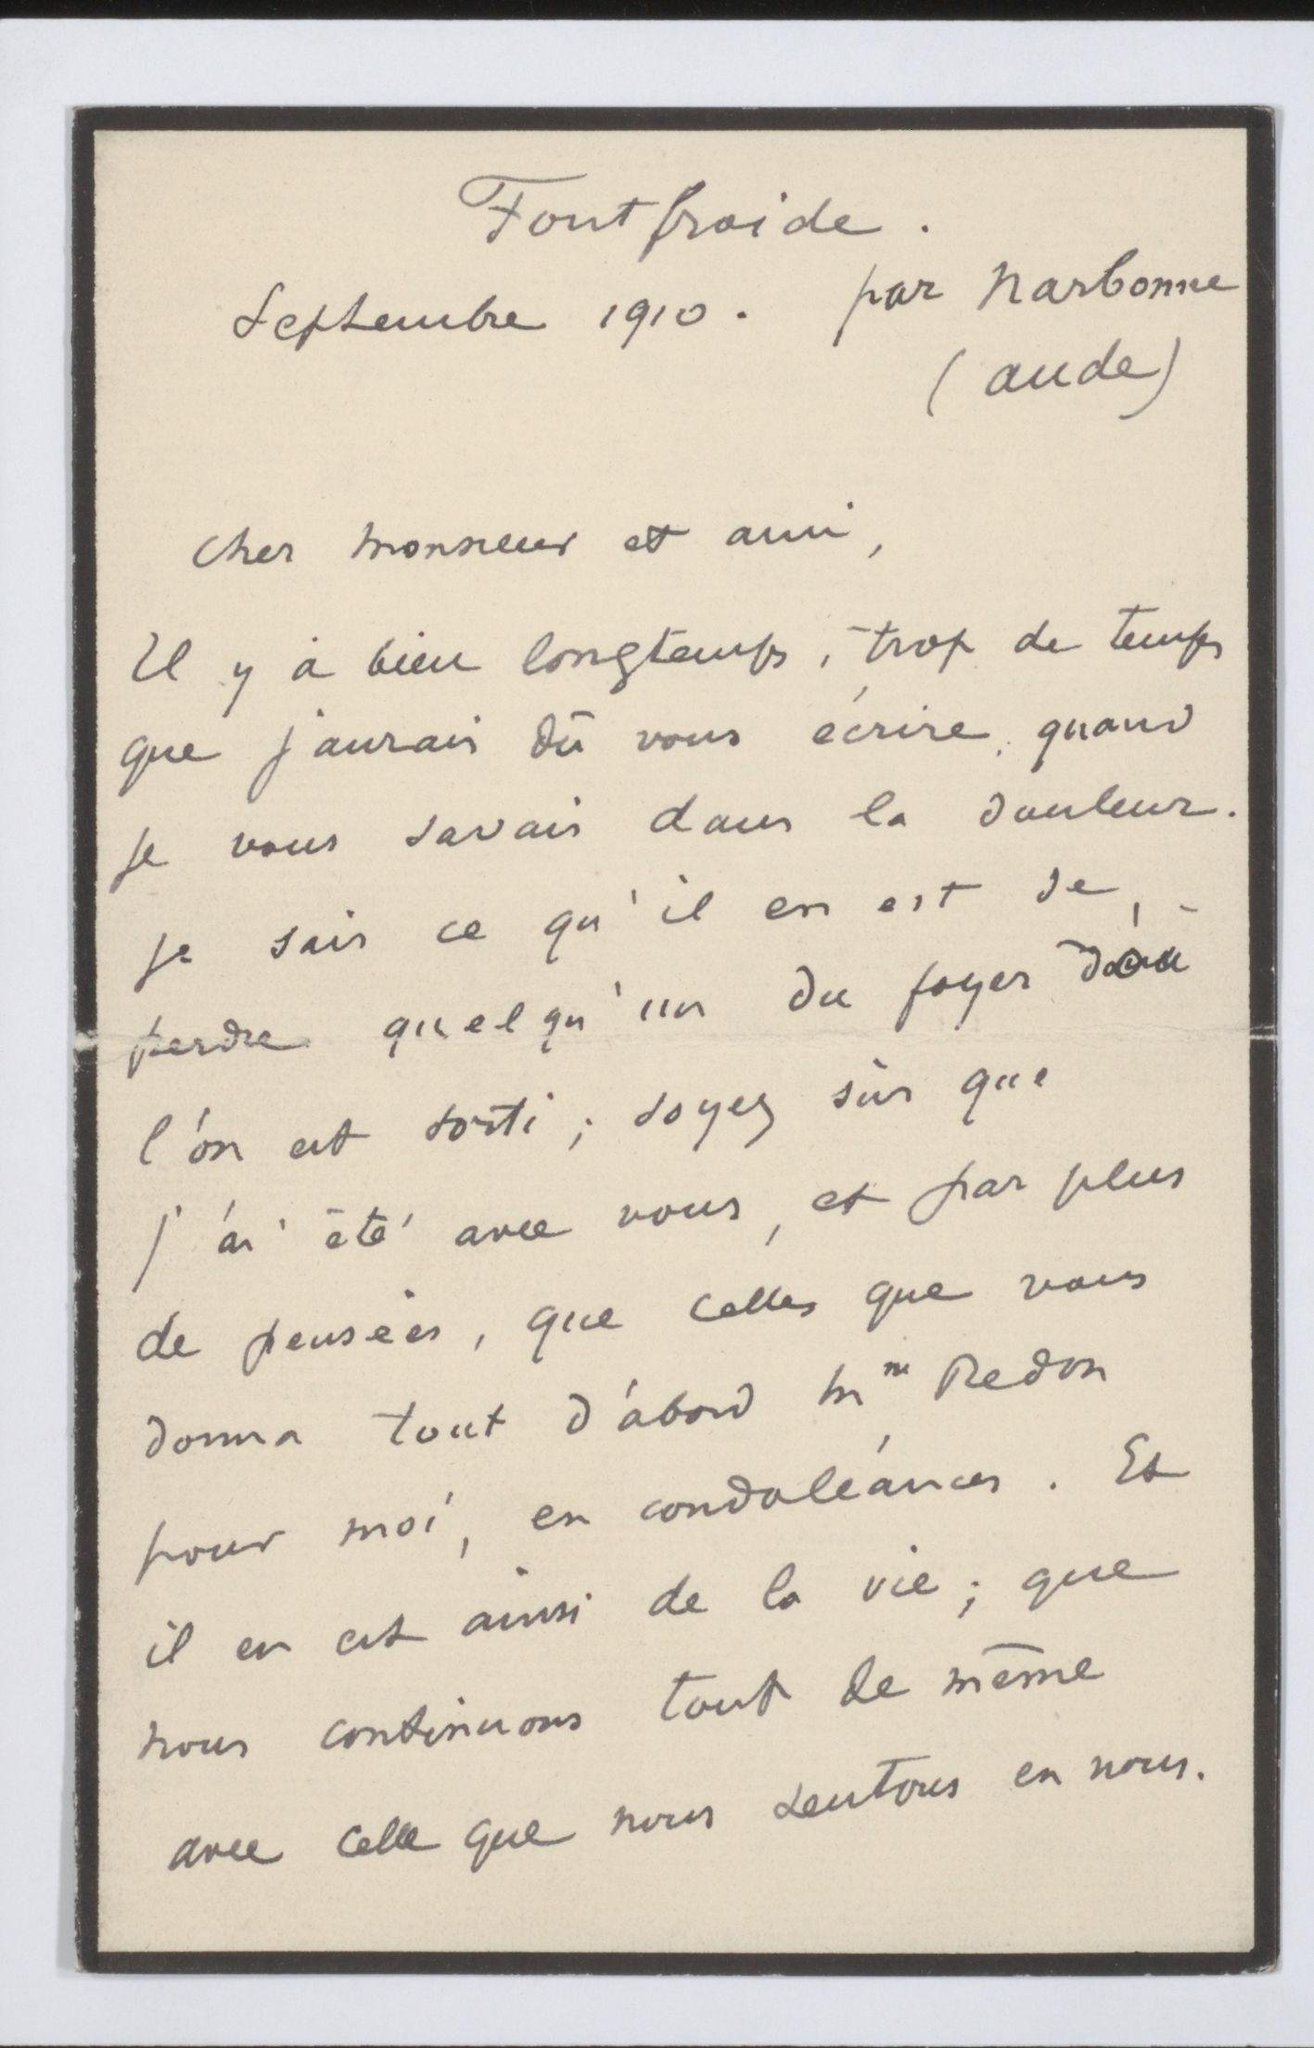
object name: letter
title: Brief aan Andries Bonger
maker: odilon redon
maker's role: draughtsman, painter, print maker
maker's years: 1840-1916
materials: ink, paper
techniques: pen, writing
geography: narbonne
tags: arï redon, ricardo viñes, painter, print maker, draughtsman, vincent van gogh, eugène fromentin-dupeux, paul cézanne, andries bonger, designer, passions, emotions, affections, music, photography, cinematography, family life, painting (including book-illumination, miniature-painting), diseases, italy, paris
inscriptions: watermark